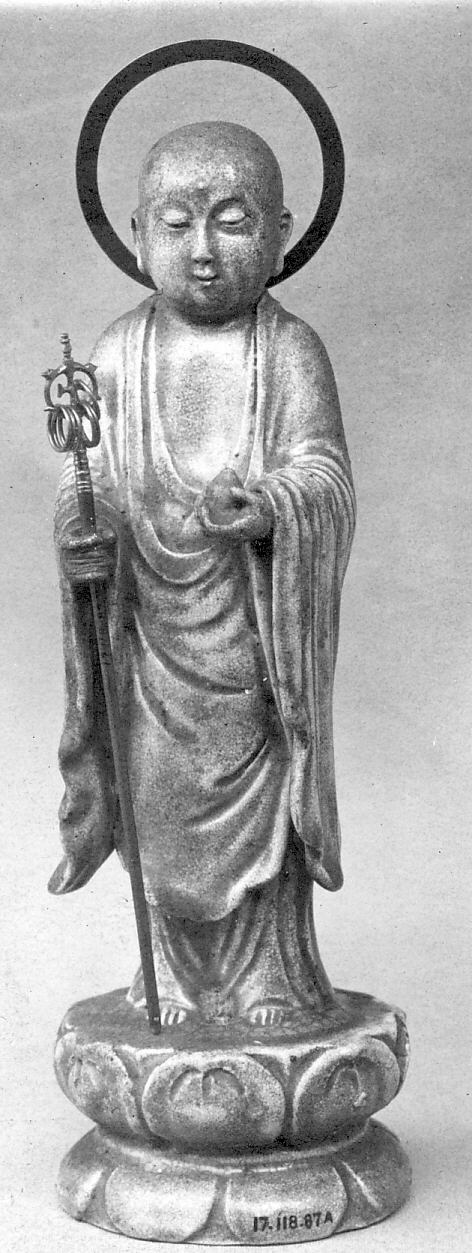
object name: statuette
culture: japanese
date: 1701-1800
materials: gold, silver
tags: monks